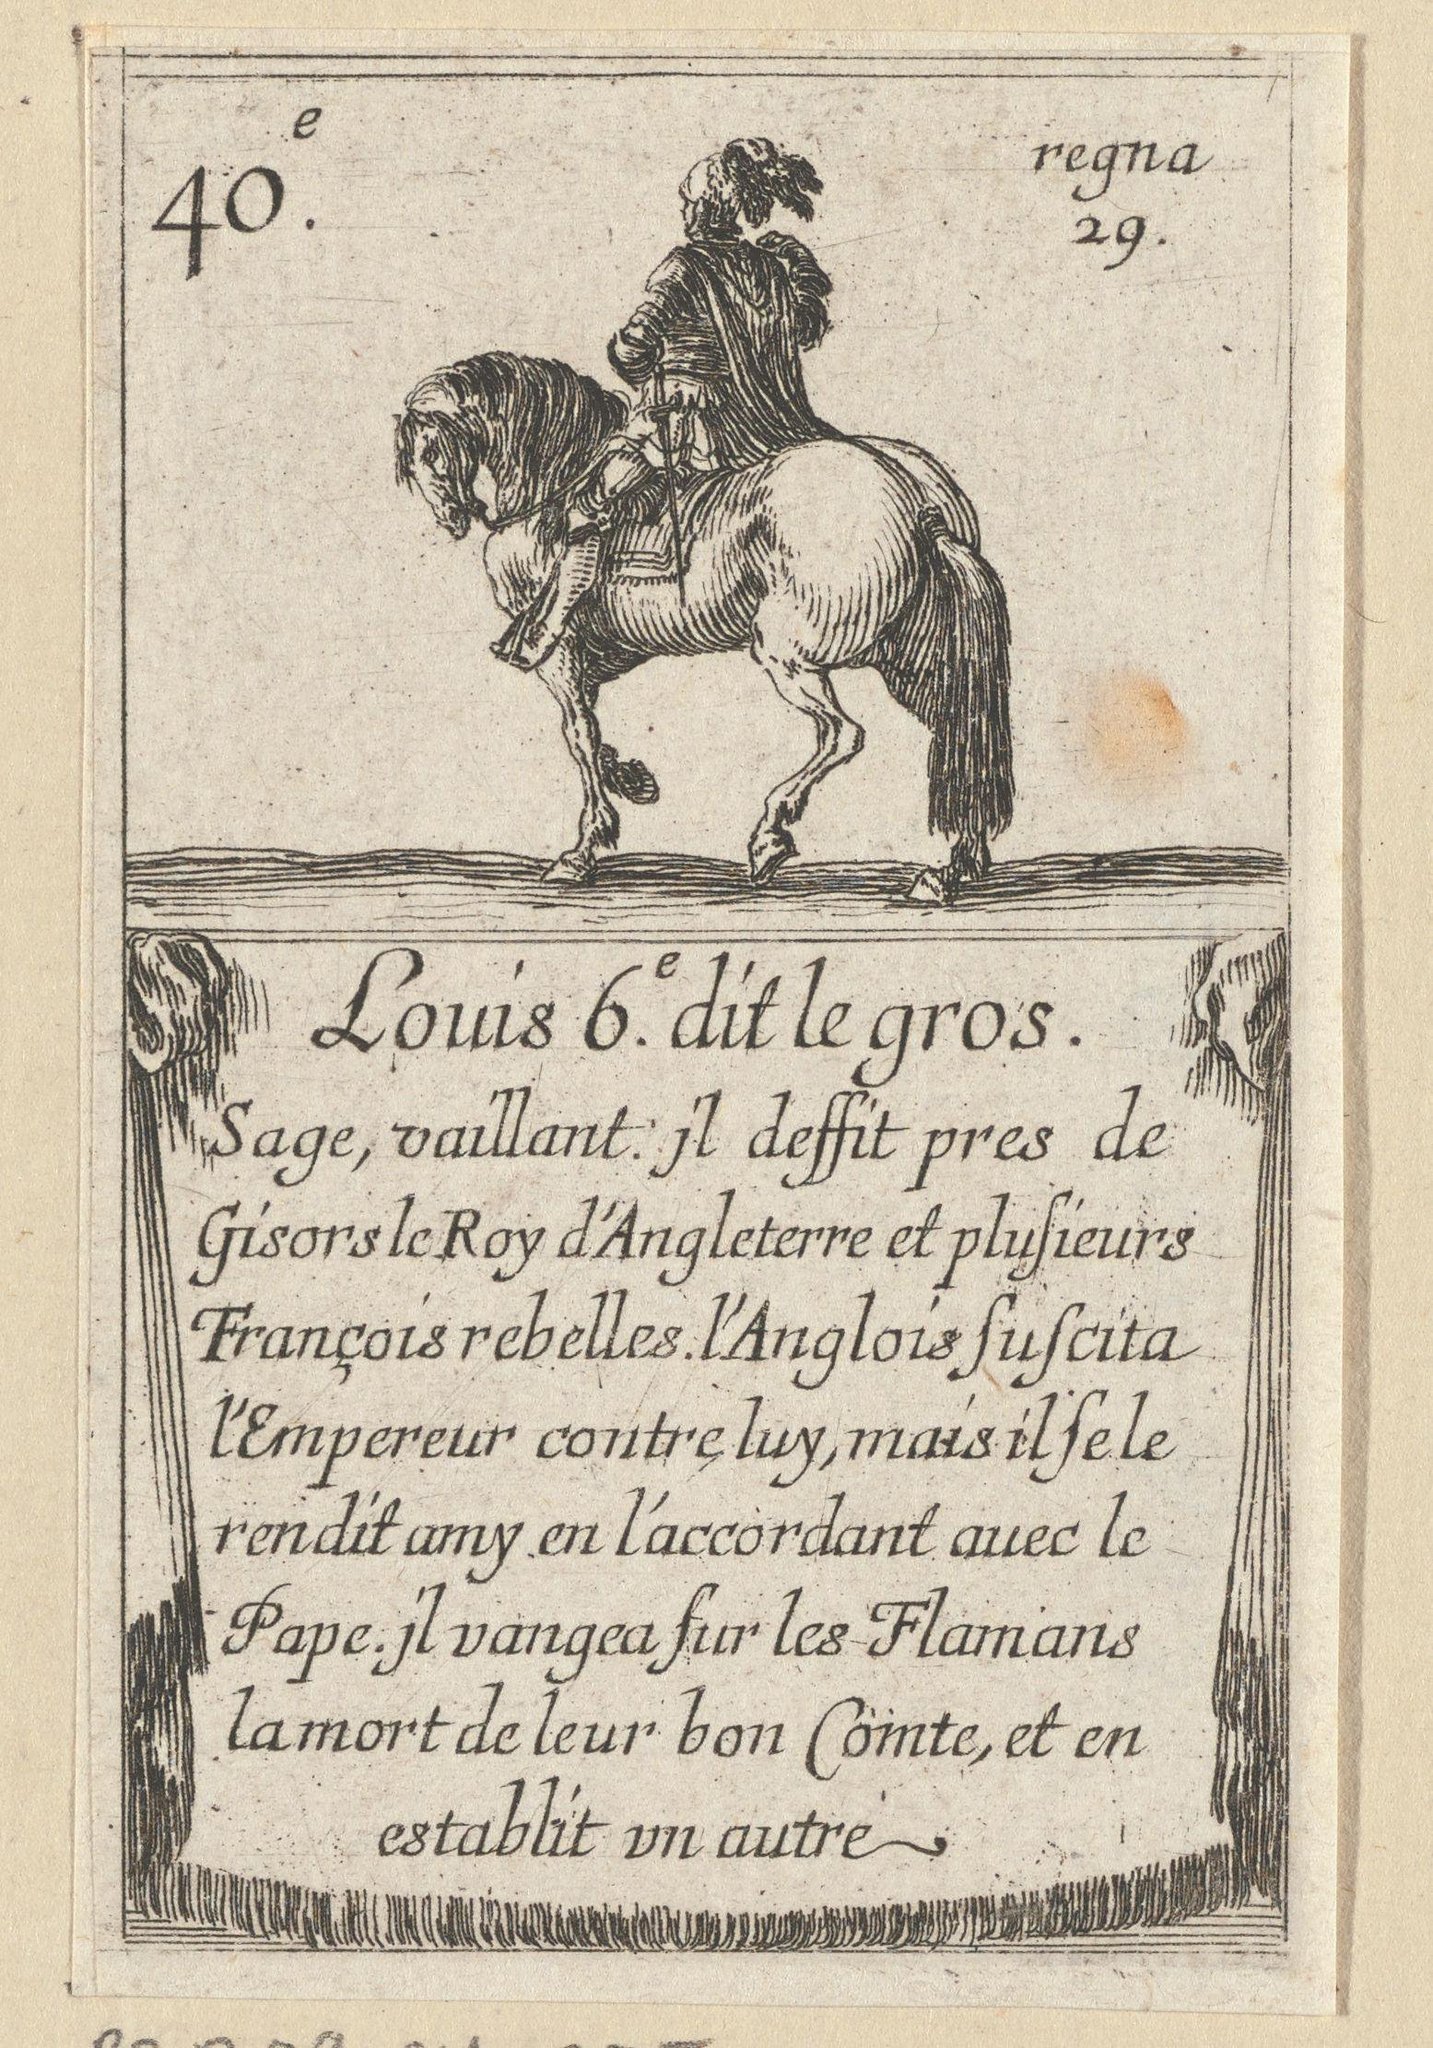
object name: print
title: Lodewijk VI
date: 1620-1664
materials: paper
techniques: etching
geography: paris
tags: paris, ruler, sovereign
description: Deze prent maakt deel uit van een kaartspel met 39 kaarten met voorstellingen van Franse koningen. De serie is uitgedacht door Jean Desmarests de Saint-Sorlin in opdracht van Kardinaal Mazarin. Het kaartspel werd gemaakt voor de jonge Lodewijk XIV, samen met het Jeu des Fables, Jeu des Reynes Renommées en Jeu de la géographie.